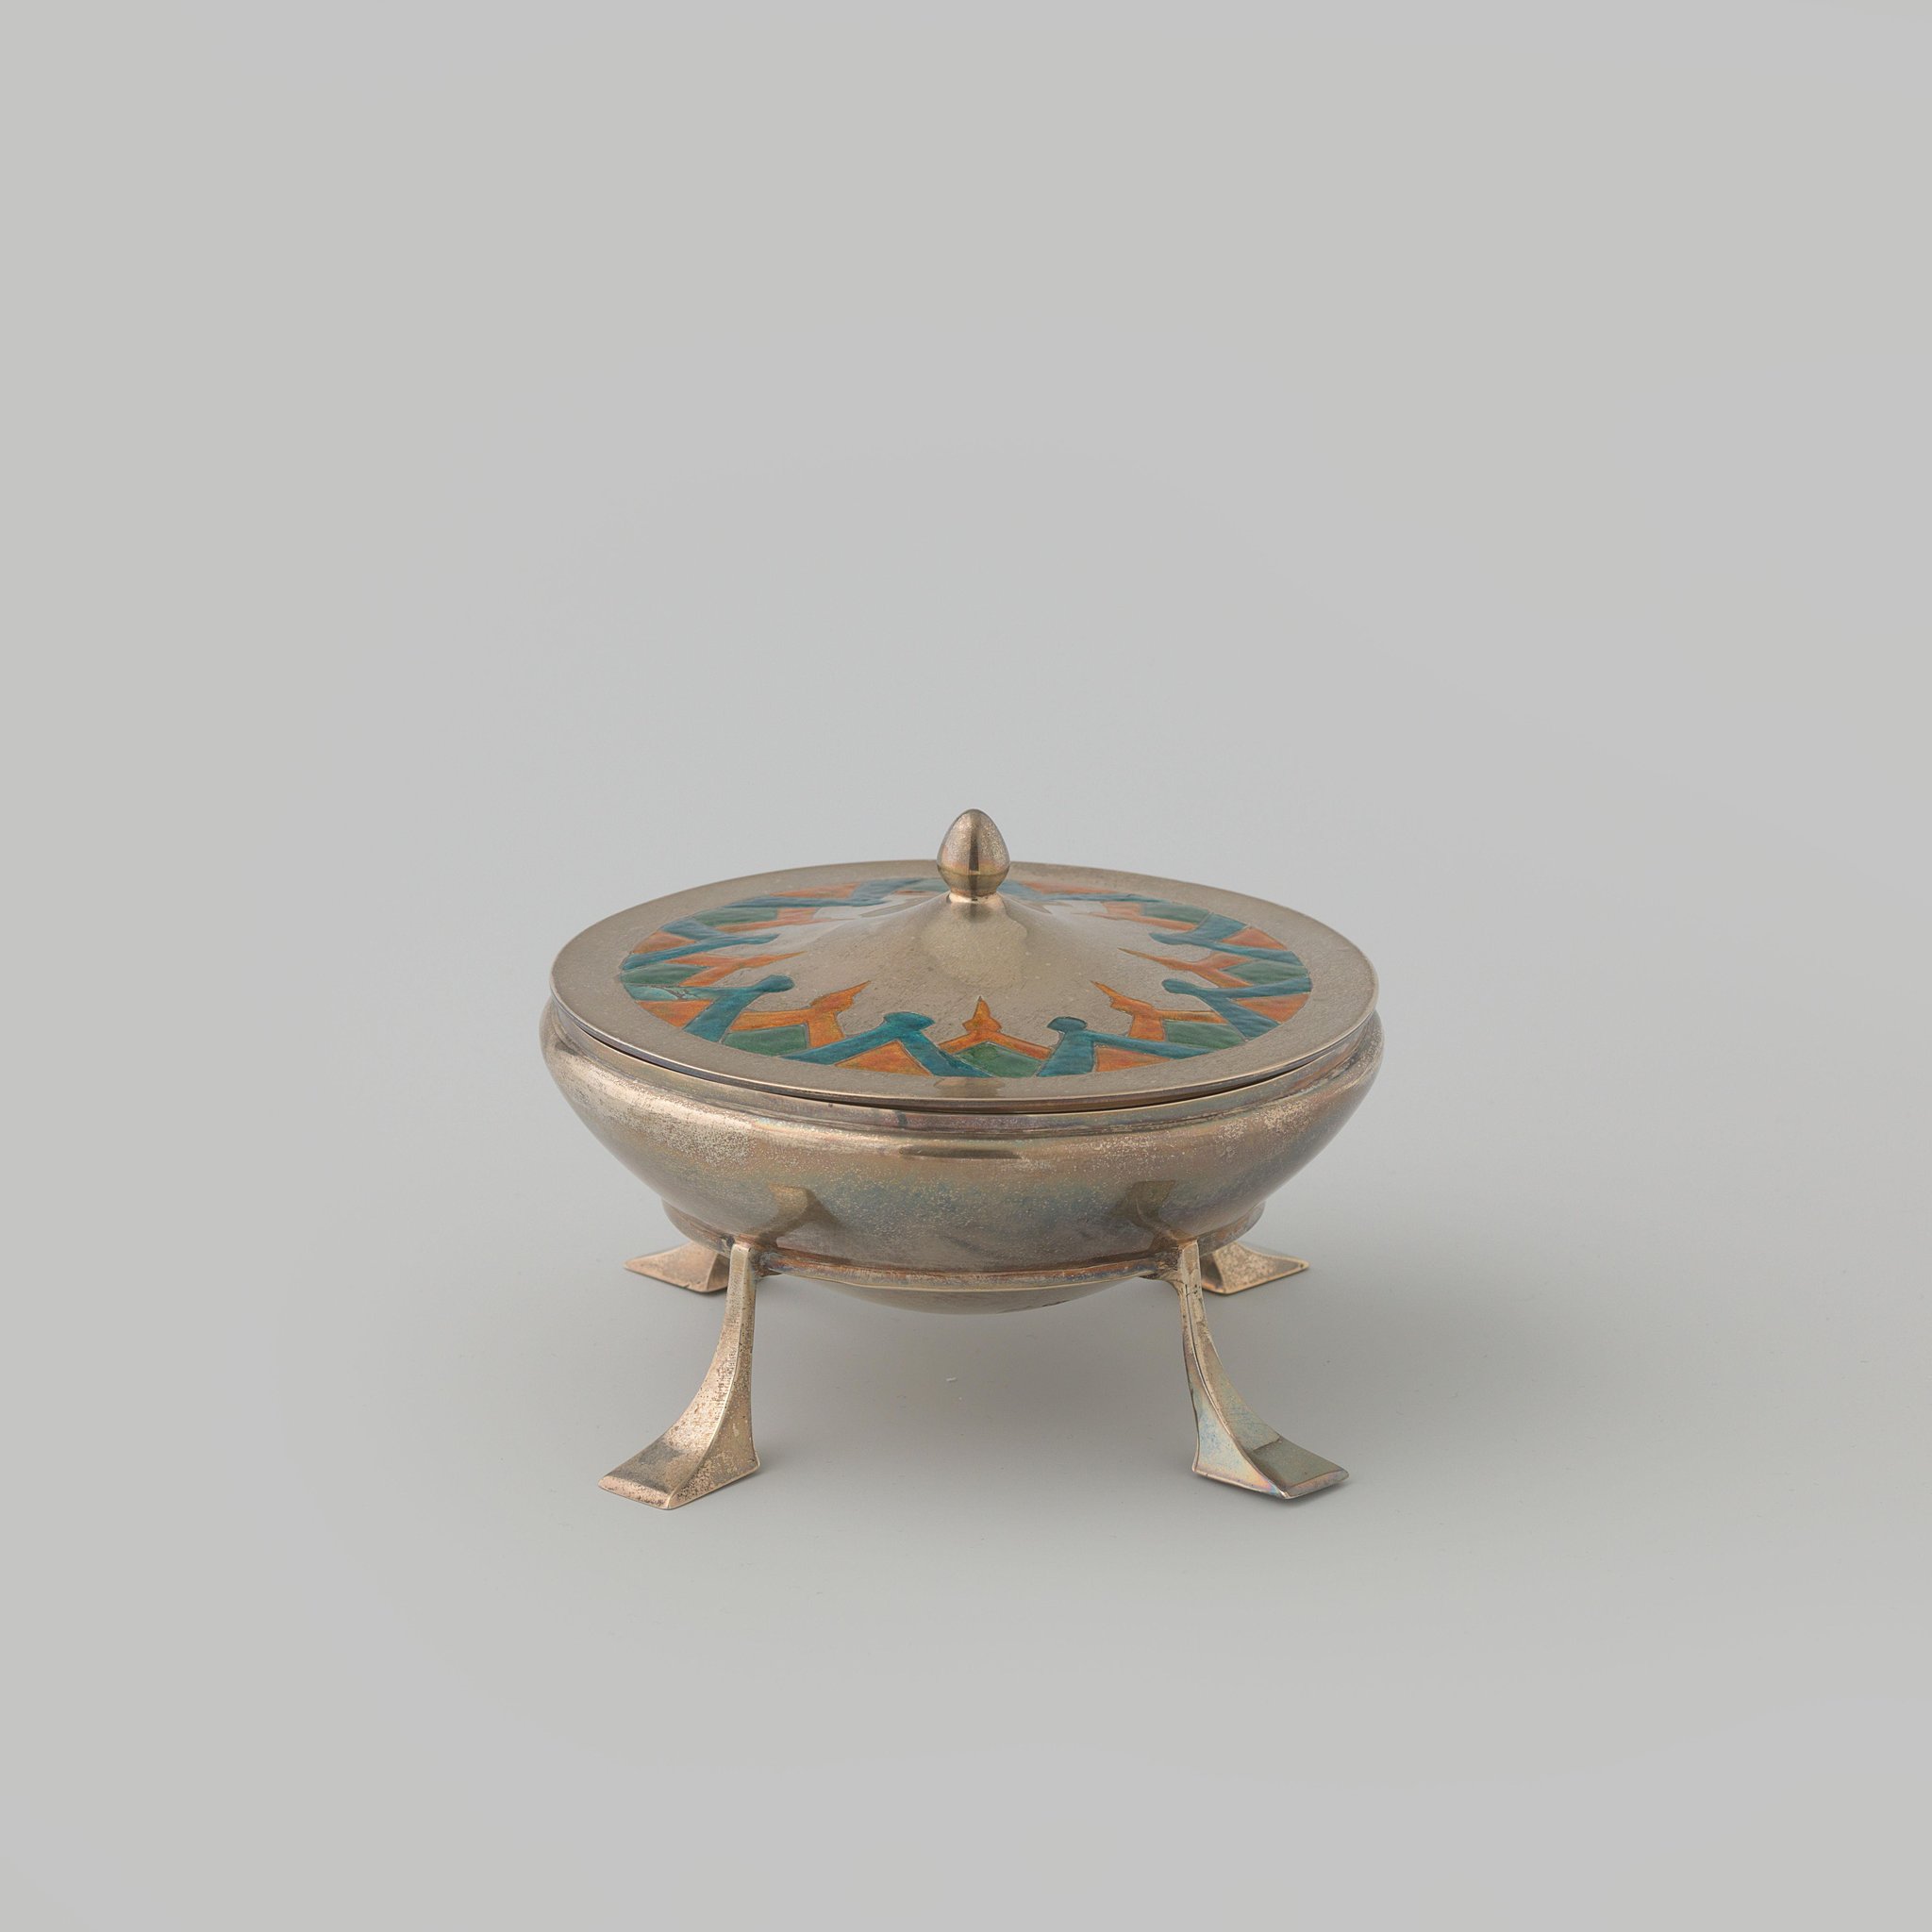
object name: compact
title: Poederdoos van zilver. Gedrukt bolvormig lichaam op vier hoge poten met licht gewelfde deksel met islamitisch aandoend ornament in émail.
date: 1900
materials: silver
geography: birmingham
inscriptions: mark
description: Poederdoos van zilver. Het gedrukt bolvormige, onversierde vat rust op vier hoge poten. Het licht gewelfde deksel is versierd met een islamitisch aandoend ornament in email.